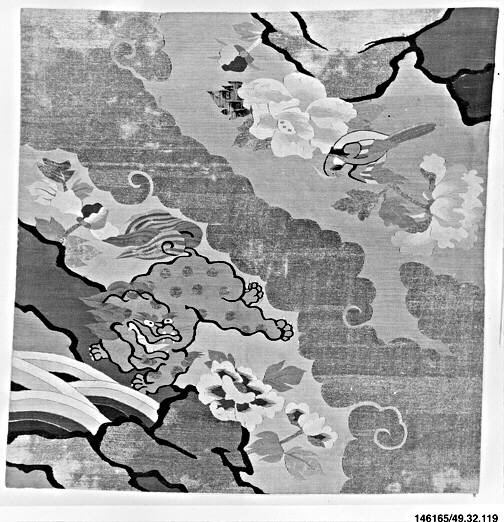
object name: gift cloth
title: Gift Cloth (Fukusa)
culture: japanese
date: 1767-1800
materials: metal thread, silk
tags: birds,lions,flowers